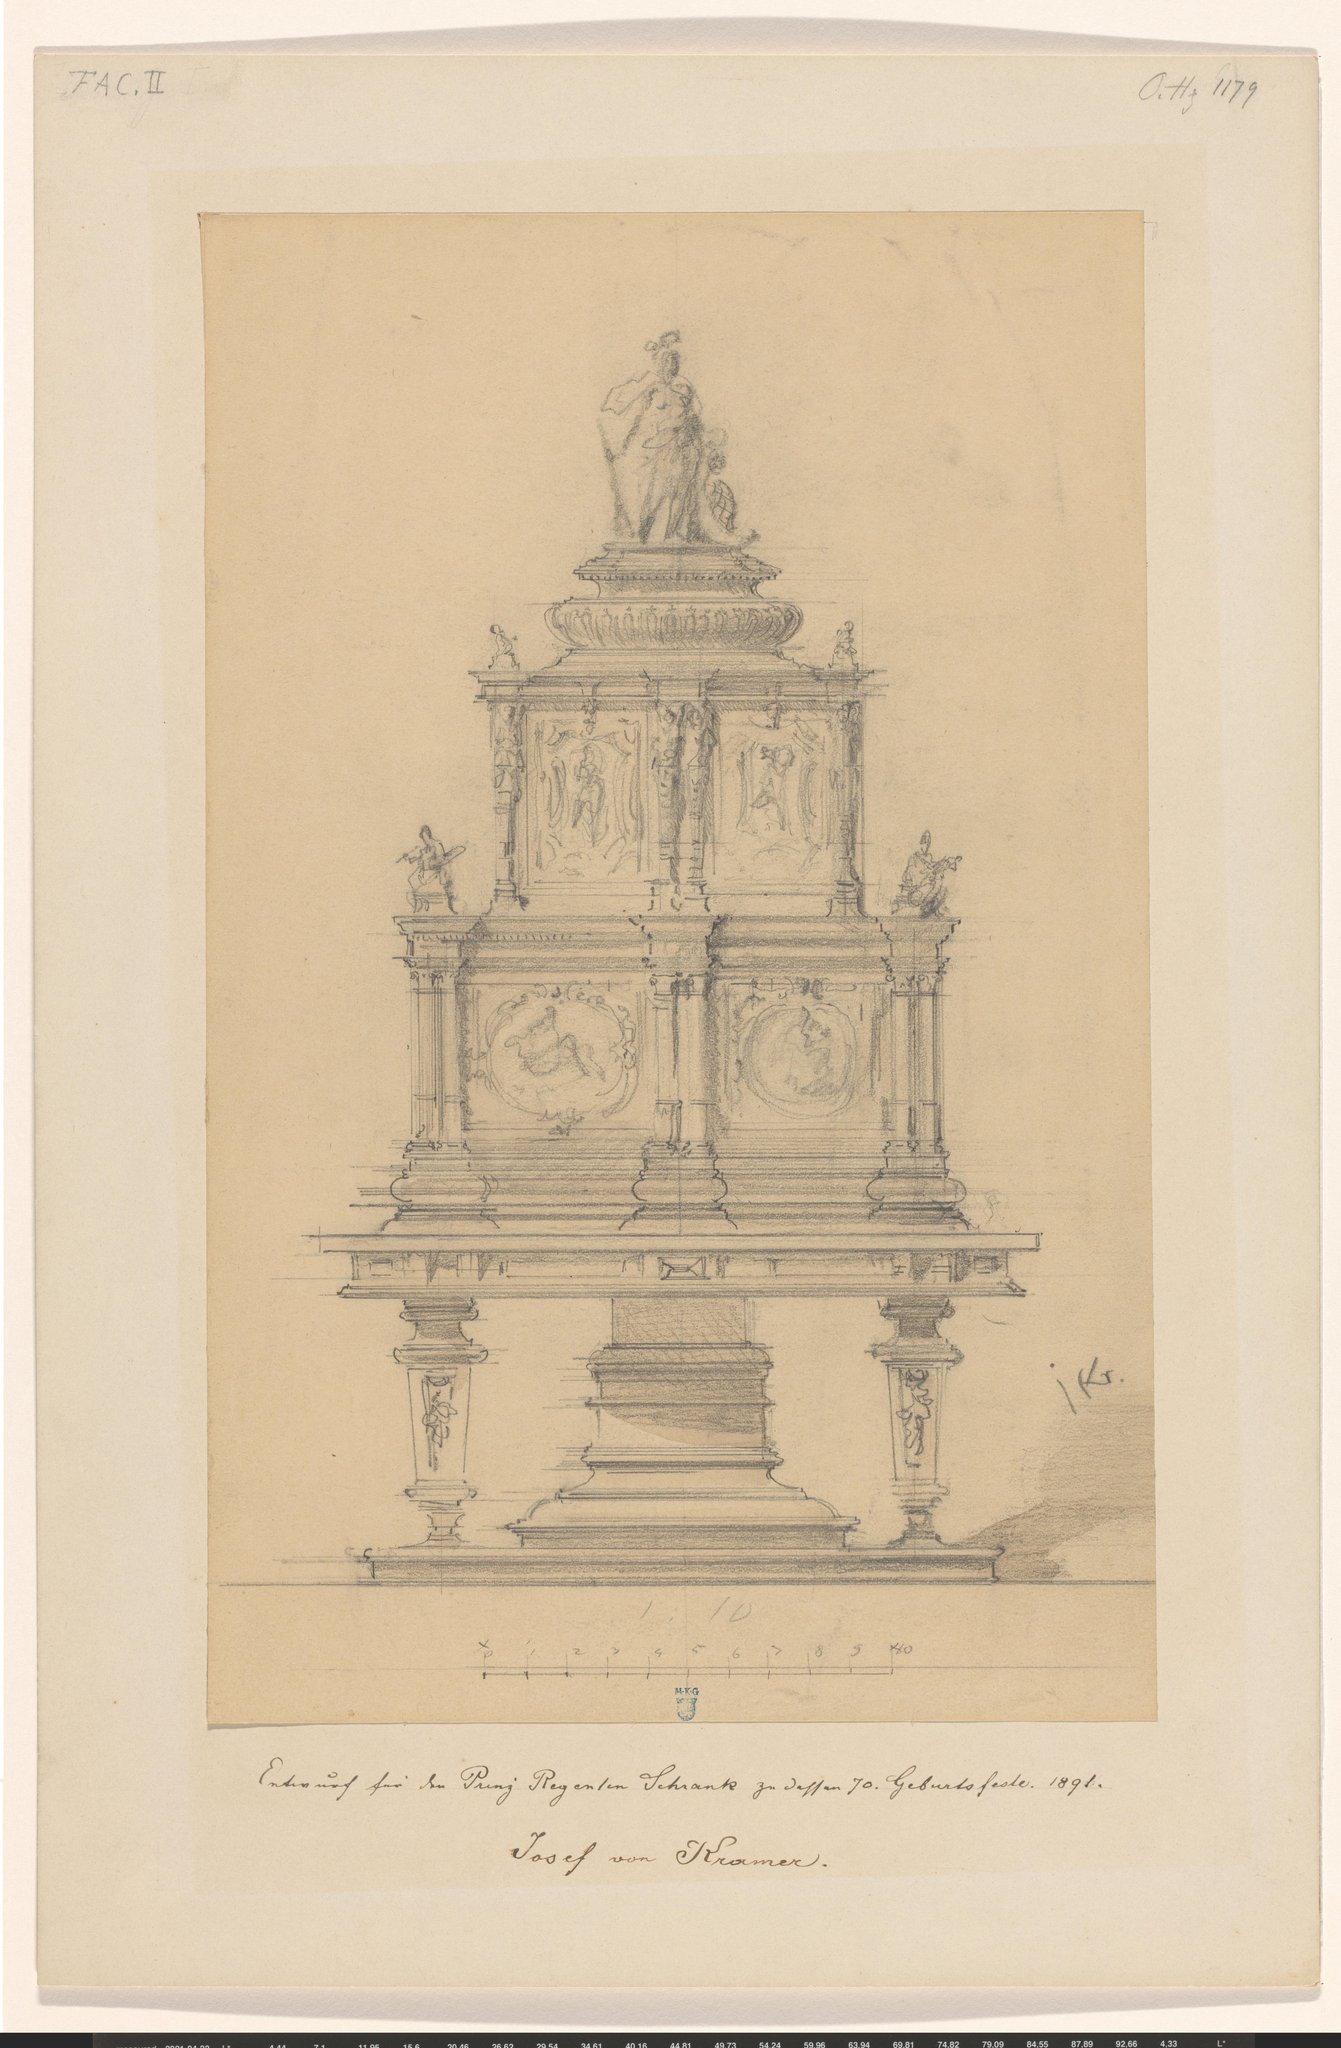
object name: drawing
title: Ontwerp voor een kast voor de 70ste verjaardag van de prins-regent Luitpold van Beieren (1812-1912)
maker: joseph von kramer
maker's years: 1841-1908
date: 1891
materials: cardboard, chalk, paper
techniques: drawing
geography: munich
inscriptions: signature: ‘I Kr. Schaal met 1 2 3 4 5 6 7 8 9 10.’, inscription: ‘FAC. II / O. Hz 1179 / Entwurf für den Prinz Regenten Schrank zu dessen 70. Geburtstagsfeste. 1891. / Josef von Kramer.’, collector's mark: ‘Münchner Künstlergenossenschaft’ Lugt 3256